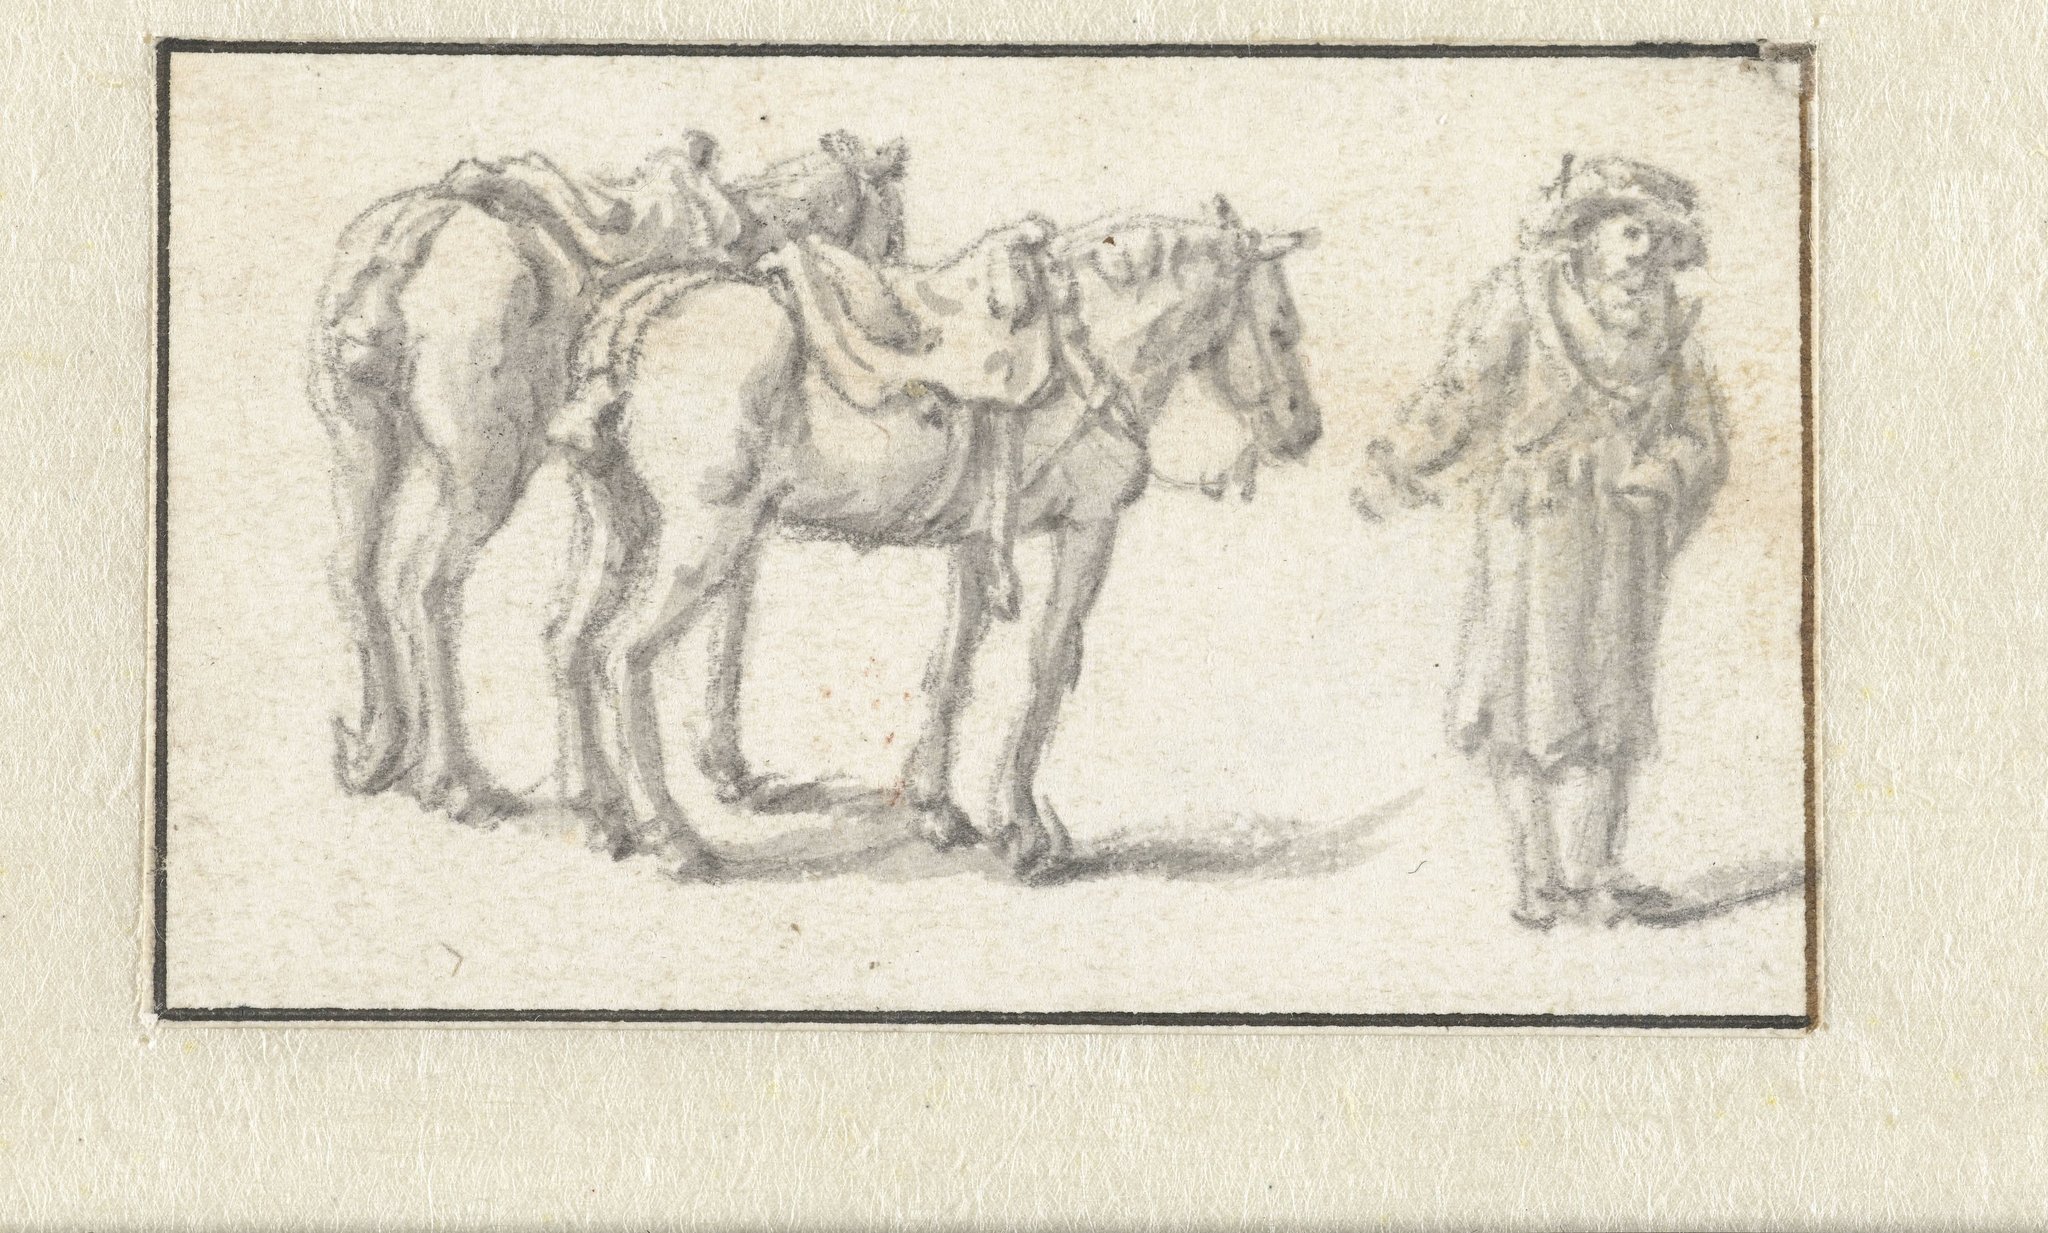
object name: drawing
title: Man staand naast twee paarden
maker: herman saftleven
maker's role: draughtsman, painter, print maker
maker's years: 1609-1685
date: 1619-1685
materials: chalk, paper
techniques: brush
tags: standing figure, horse